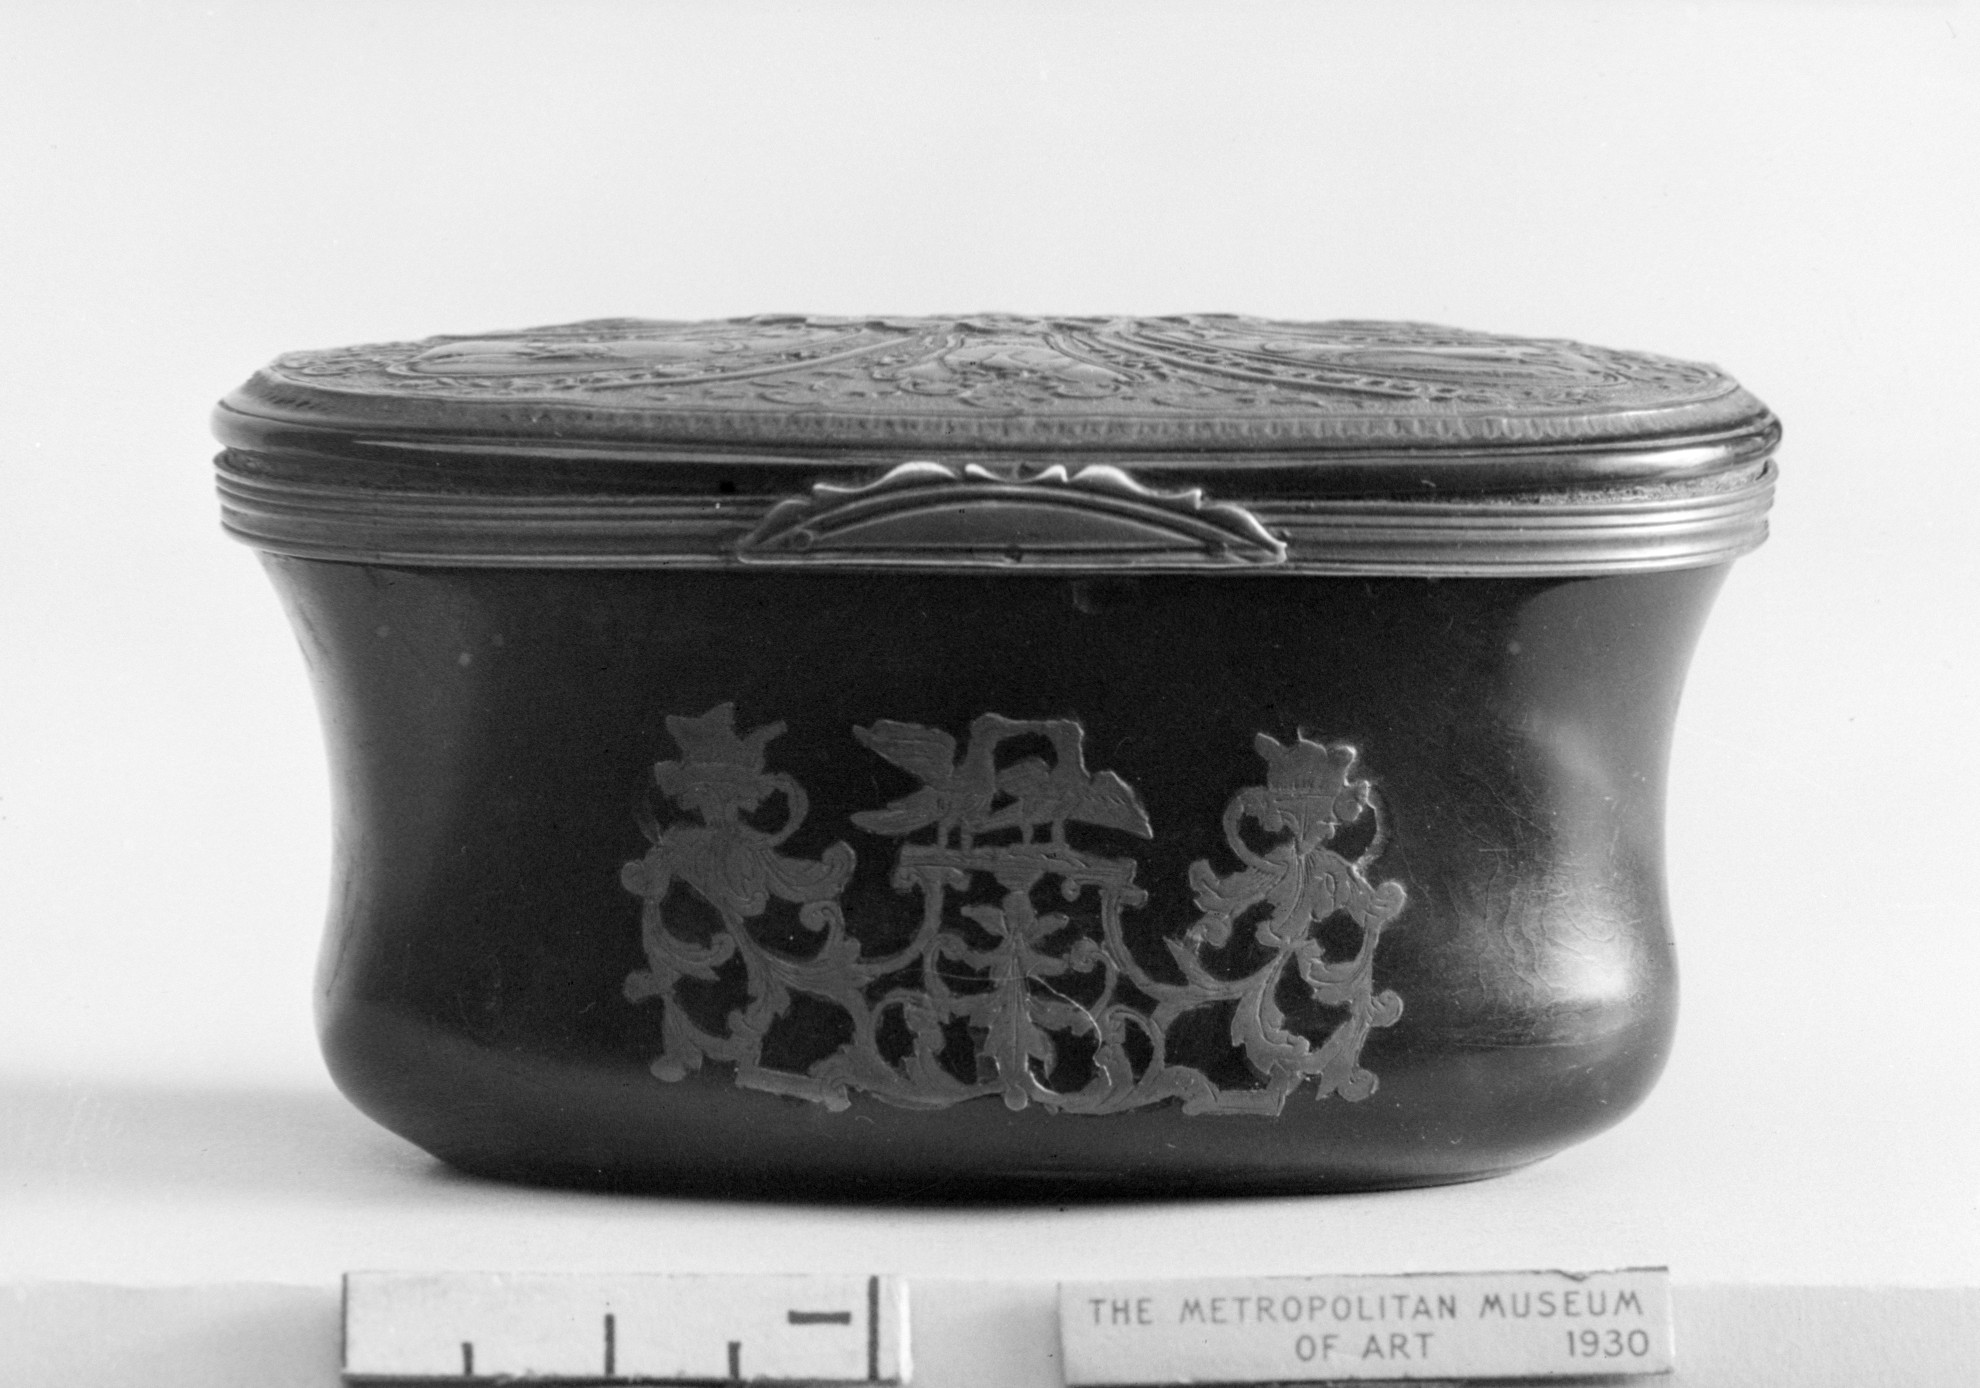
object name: snuffbox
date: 1701-1800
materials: silver, shell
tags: birds